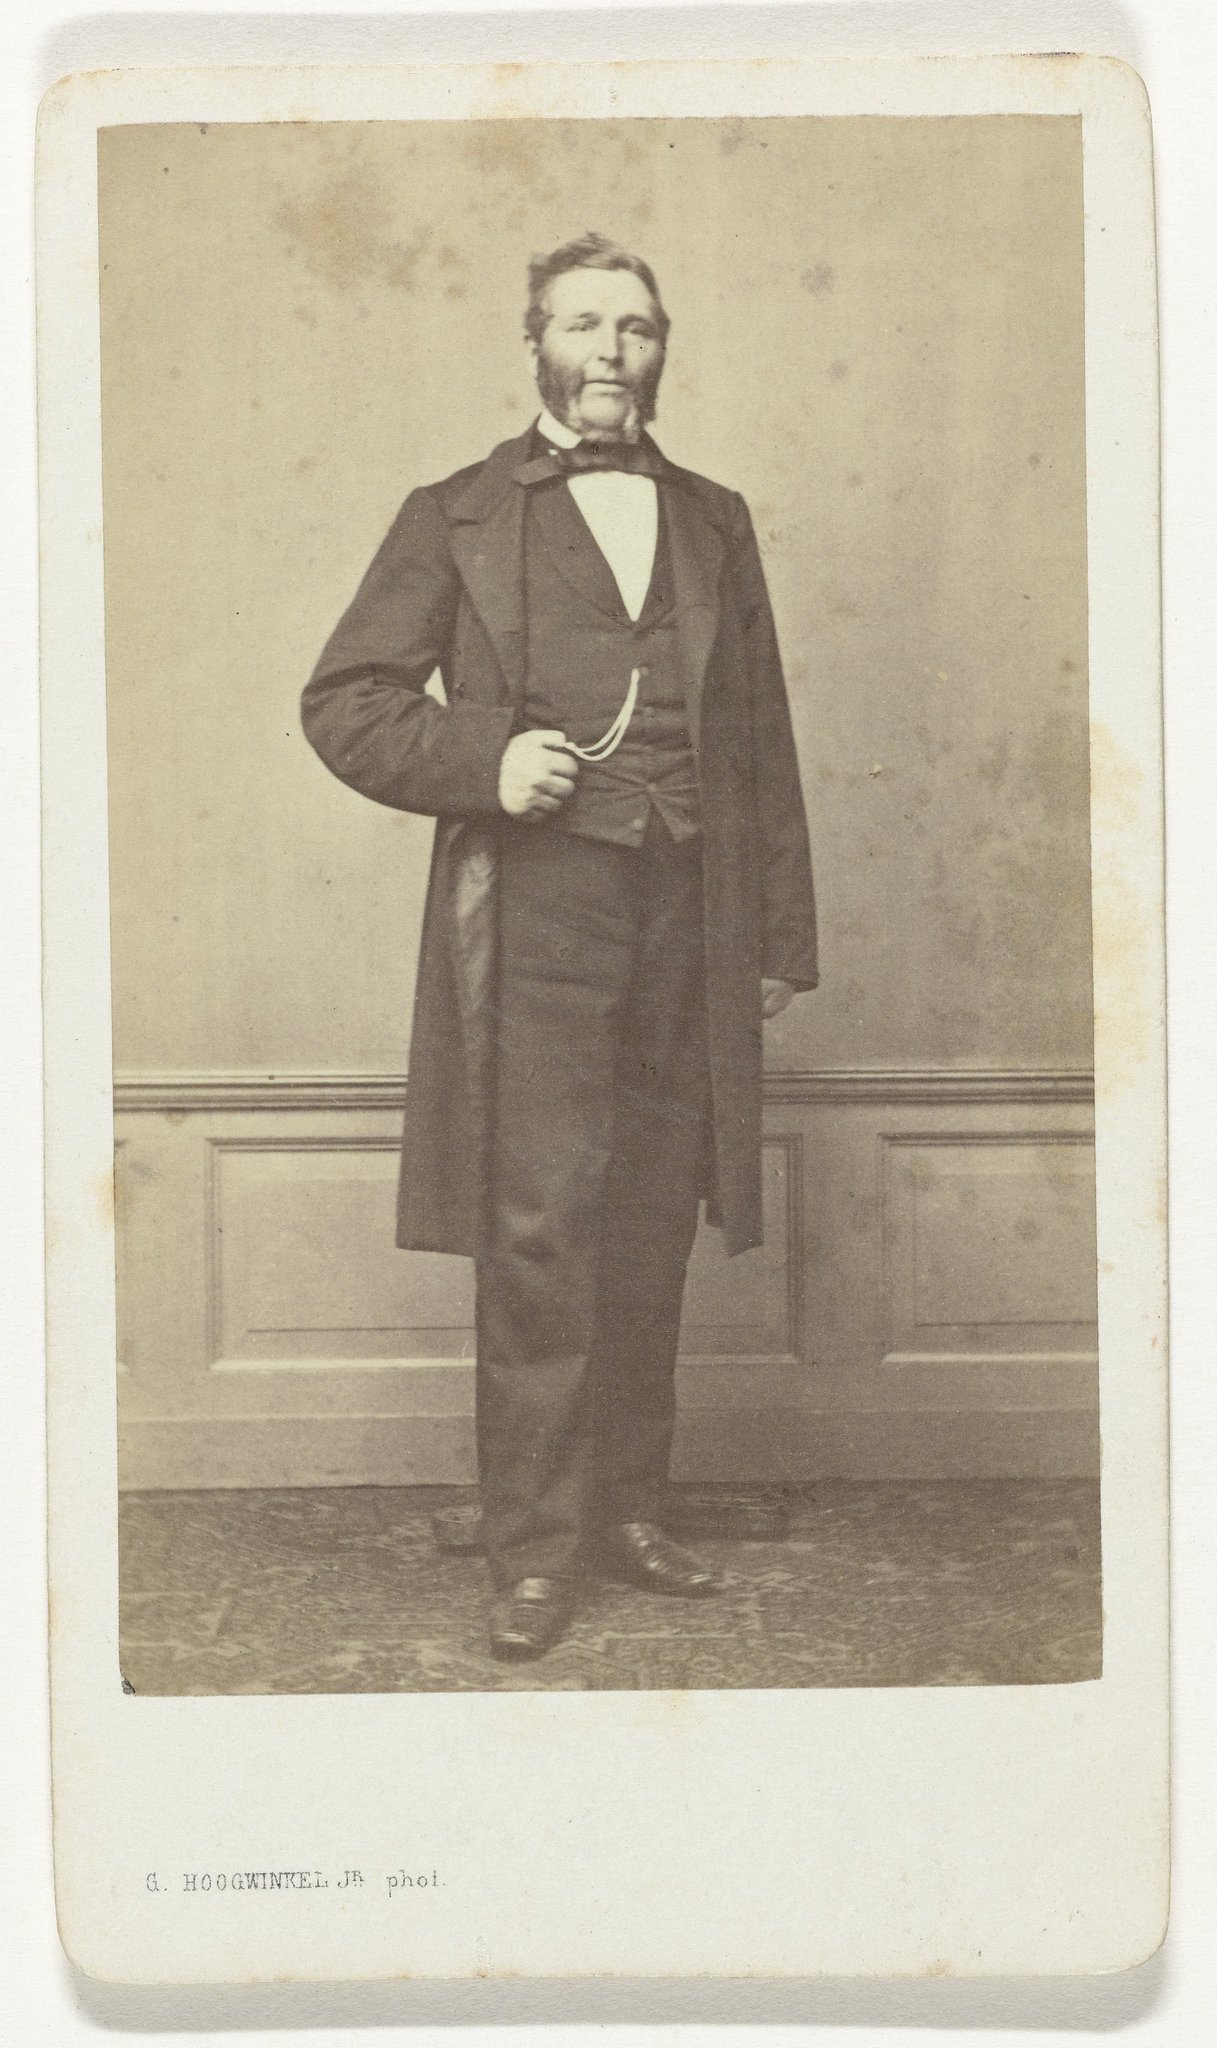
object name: carte de visite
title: Portret van een man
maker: gerrit hoogwinkel jr.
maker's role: fotograaf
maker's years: 1837-1890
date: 1865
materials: cardboard, paper, photographic support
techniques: albumen print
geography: rotterdam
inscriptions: signature and address: ‘G. Hoogwinkel jr/Photographe/Rotterdam/56, Hoogstraat’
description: Staande man met bakkebaarden, zijn hand op zijn horlogeketting, ten voeten uit.